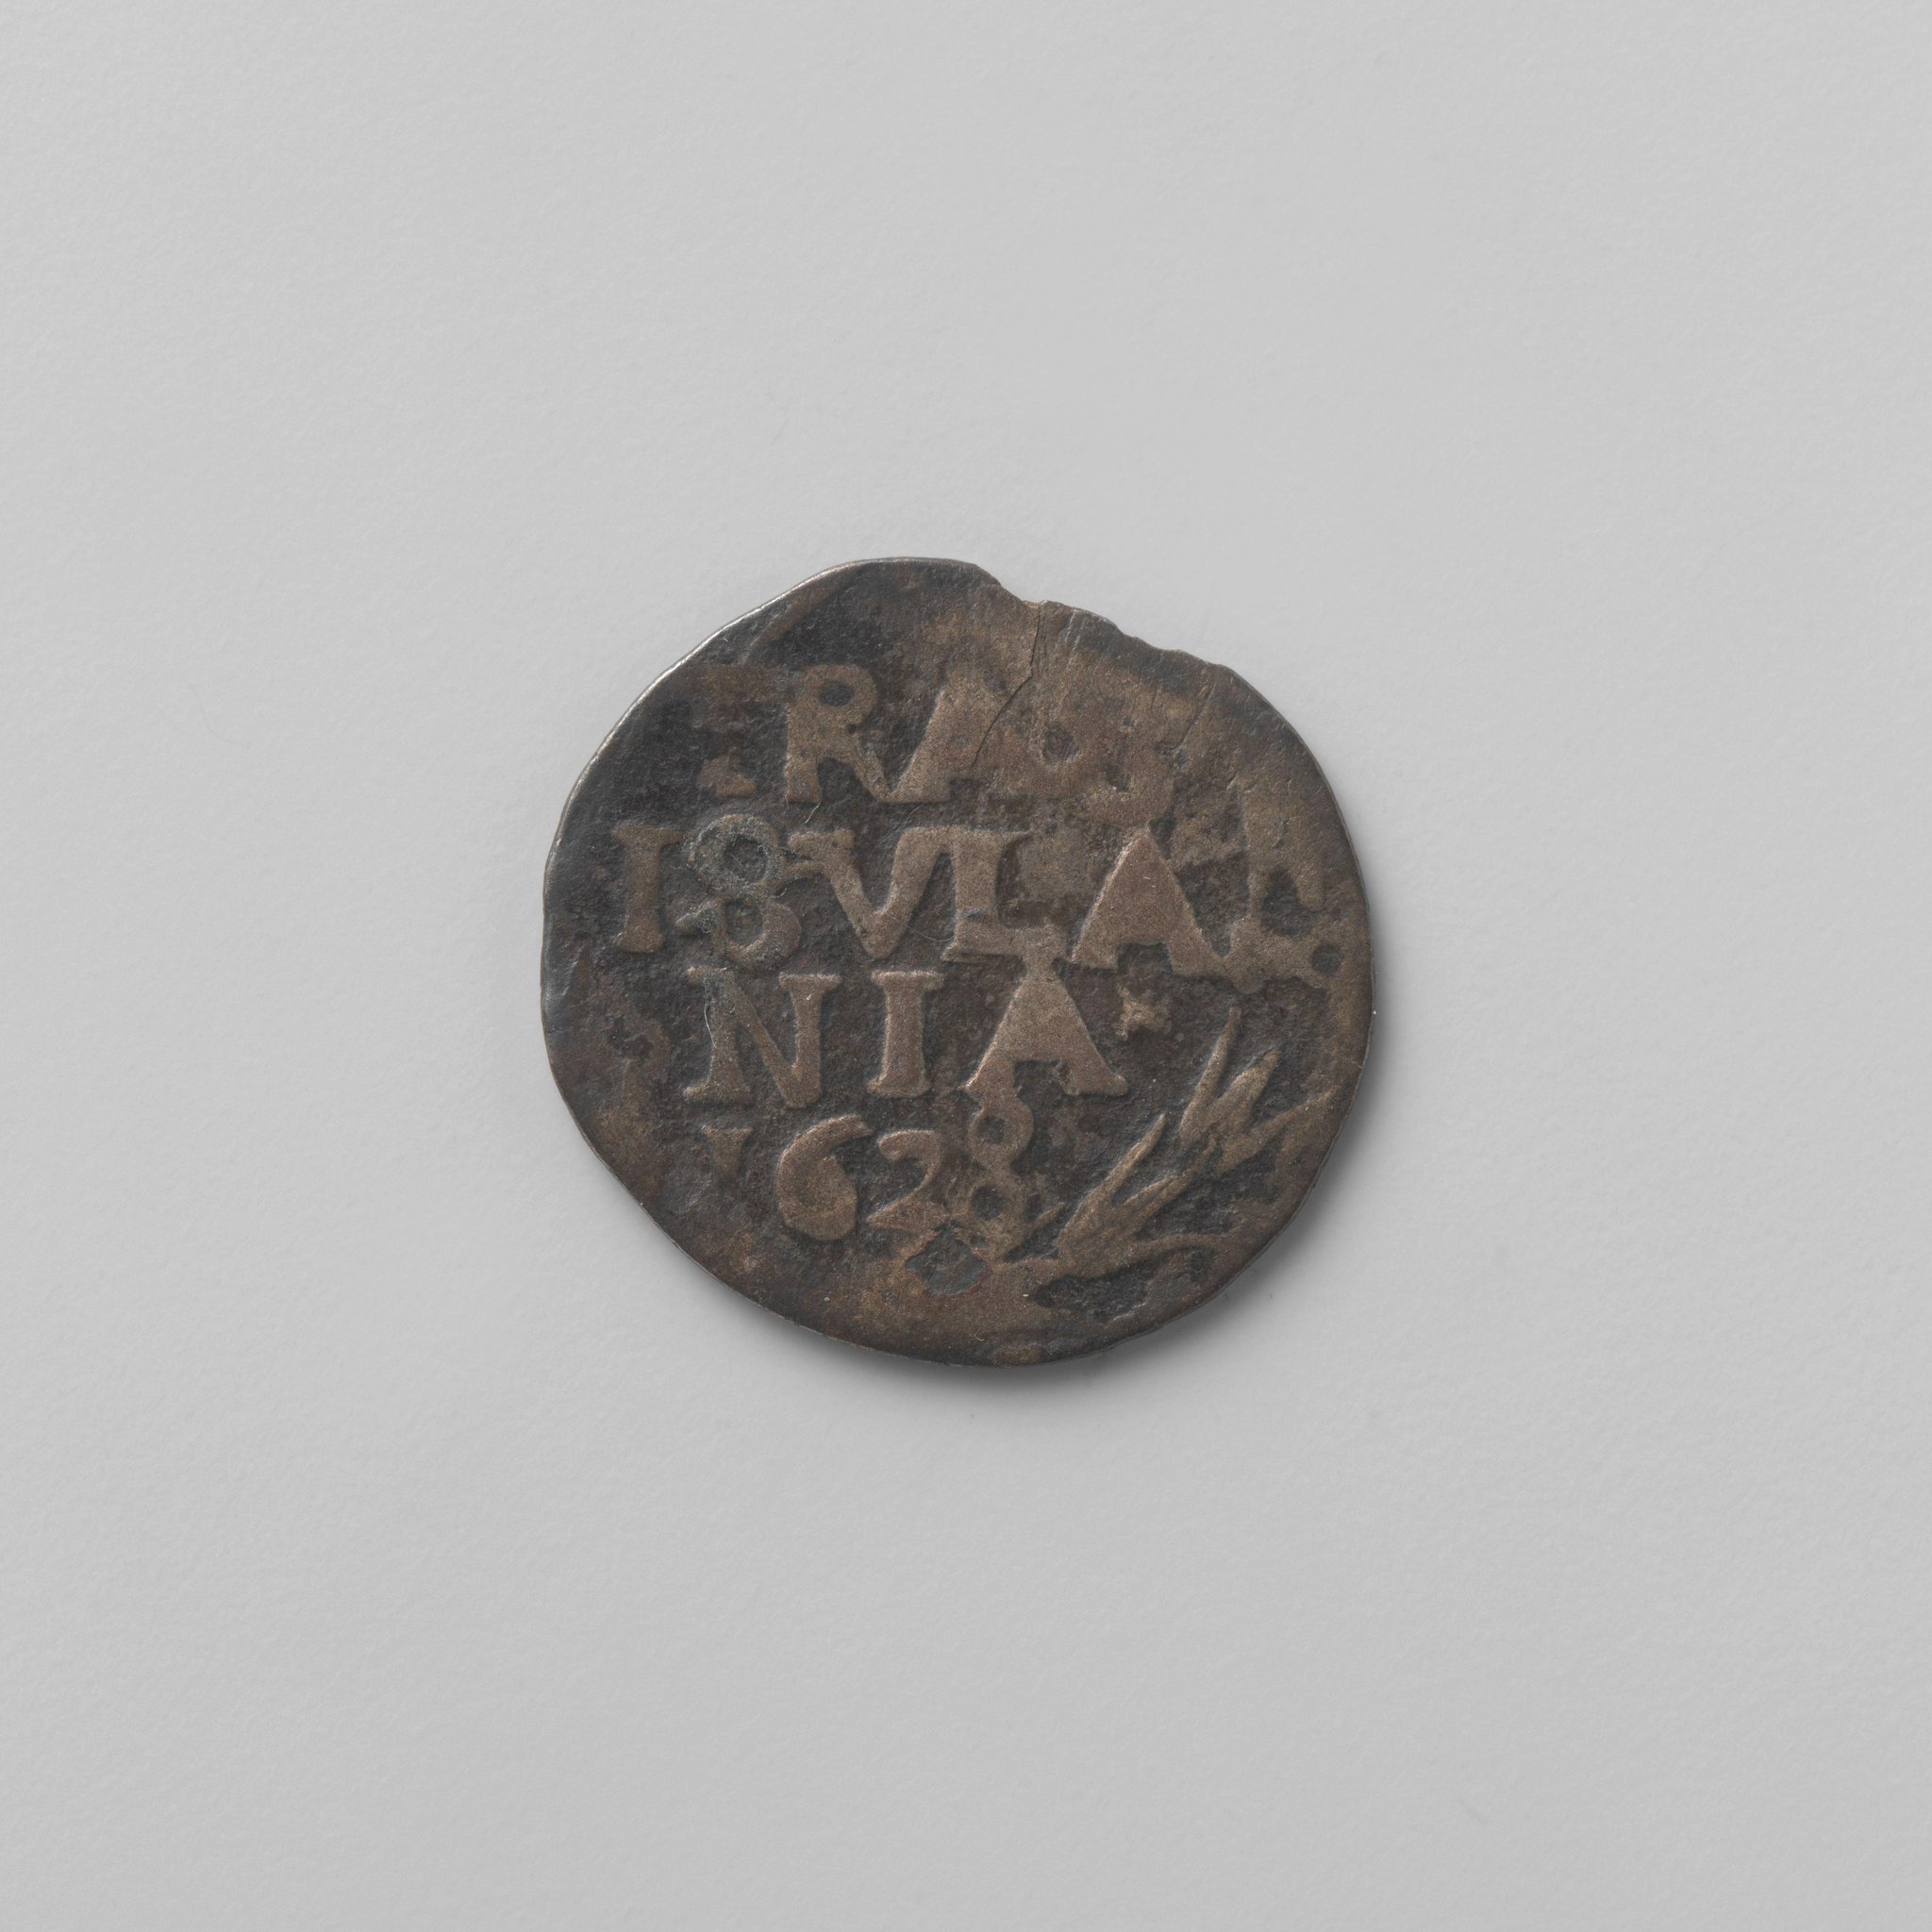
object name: coin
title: Overijsselse bezemstuiver, 1628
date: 1628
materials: silver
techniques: striking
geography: kampen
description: Zilveren munt. Voorzijde: binnen lauwerkrans drieregelig opschrift, waaronder jaartal. Keerzijde: binnen lauwerkrans tussen waarde-aanduiding I S pijlenbundel.